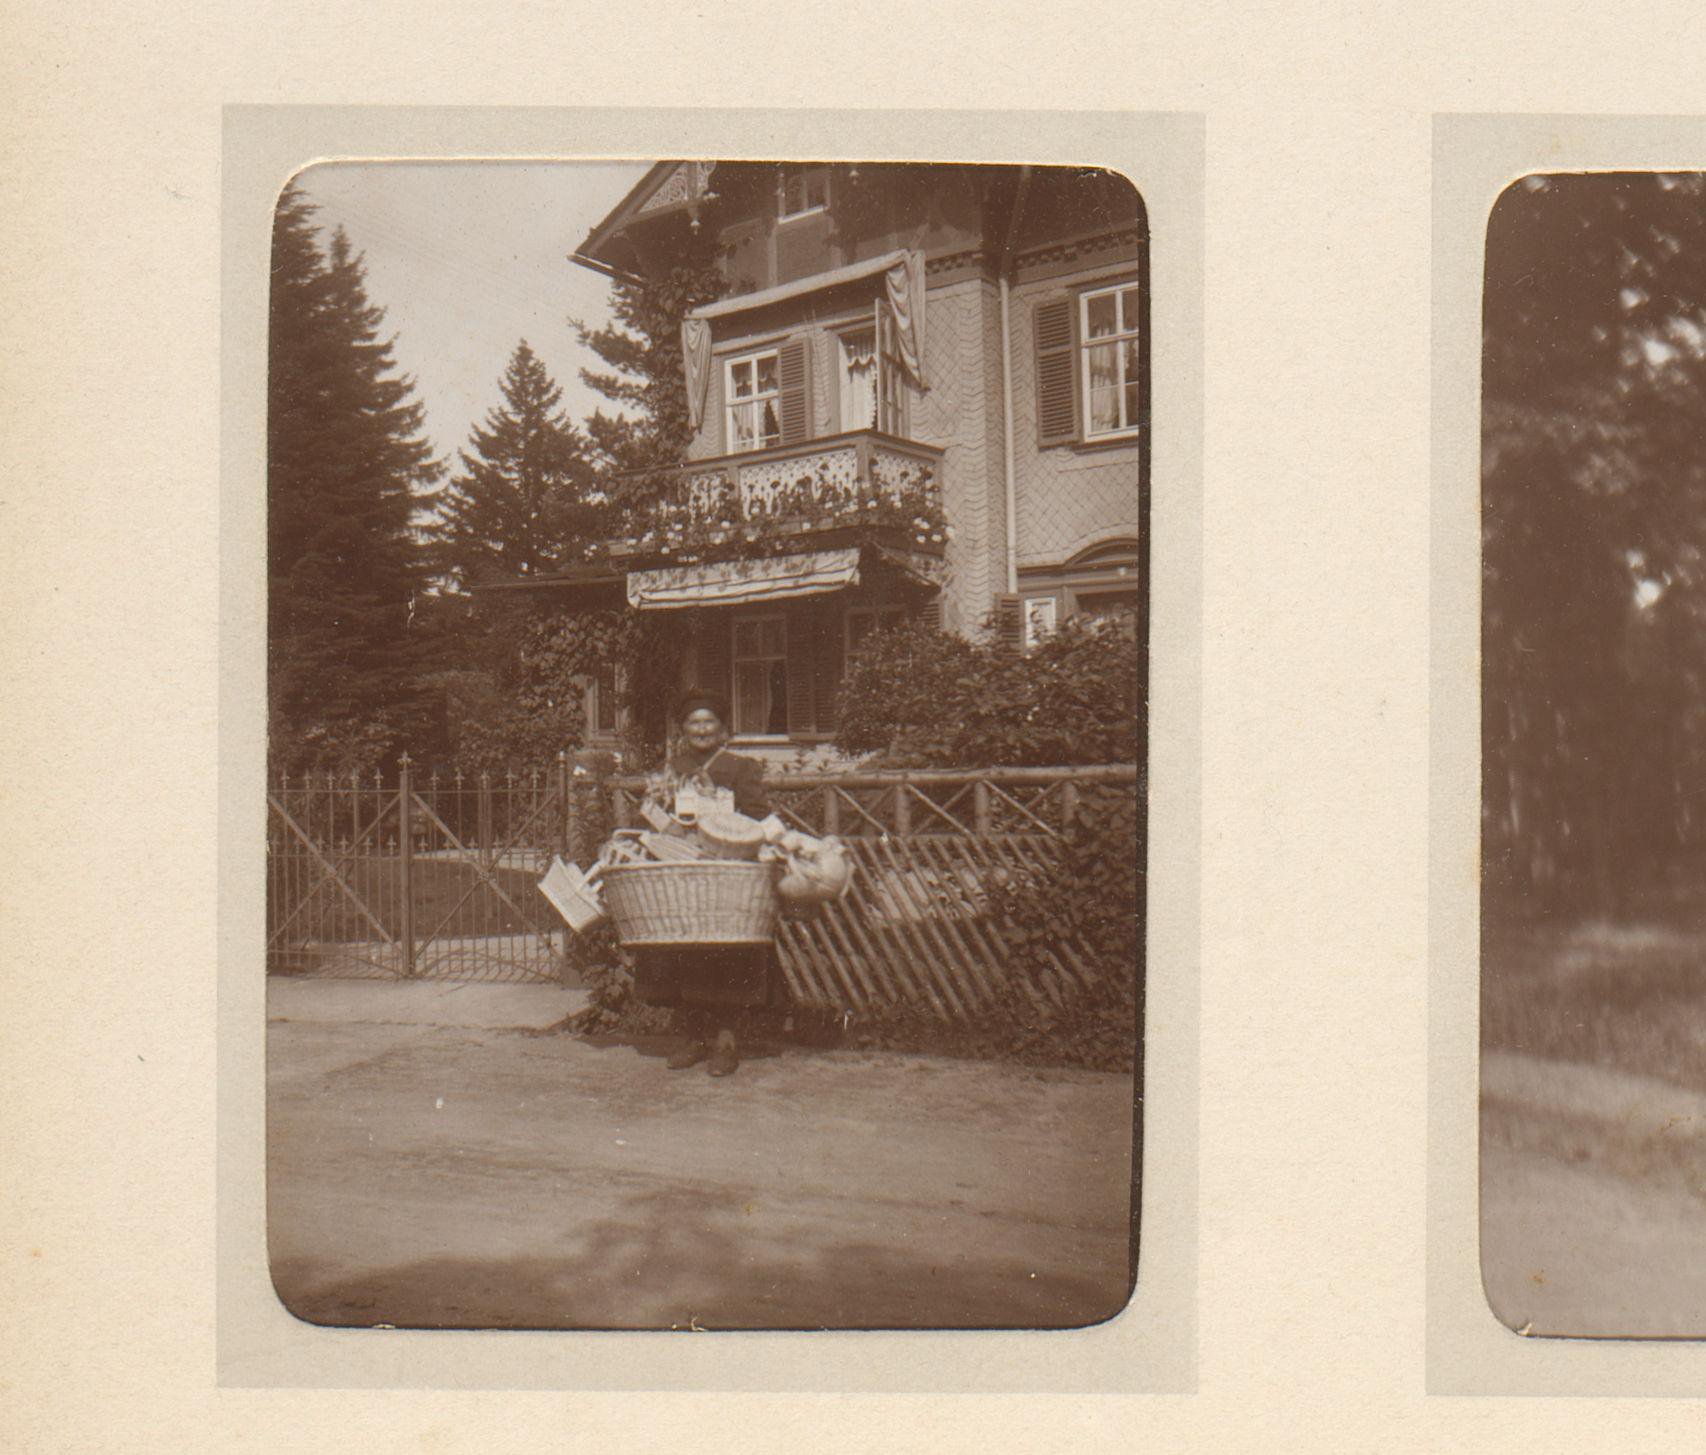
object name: album leaf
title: Portret van een onbekende vrouw met diverse manden aan haar arm, staande voor een huis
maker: liesbeth overhoff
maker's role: fotograaf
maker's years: 1895-1969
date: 1910-1915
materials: paper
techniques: collodion silver print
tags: historical persons - bb - woman, container made of plant material other than wood: basket